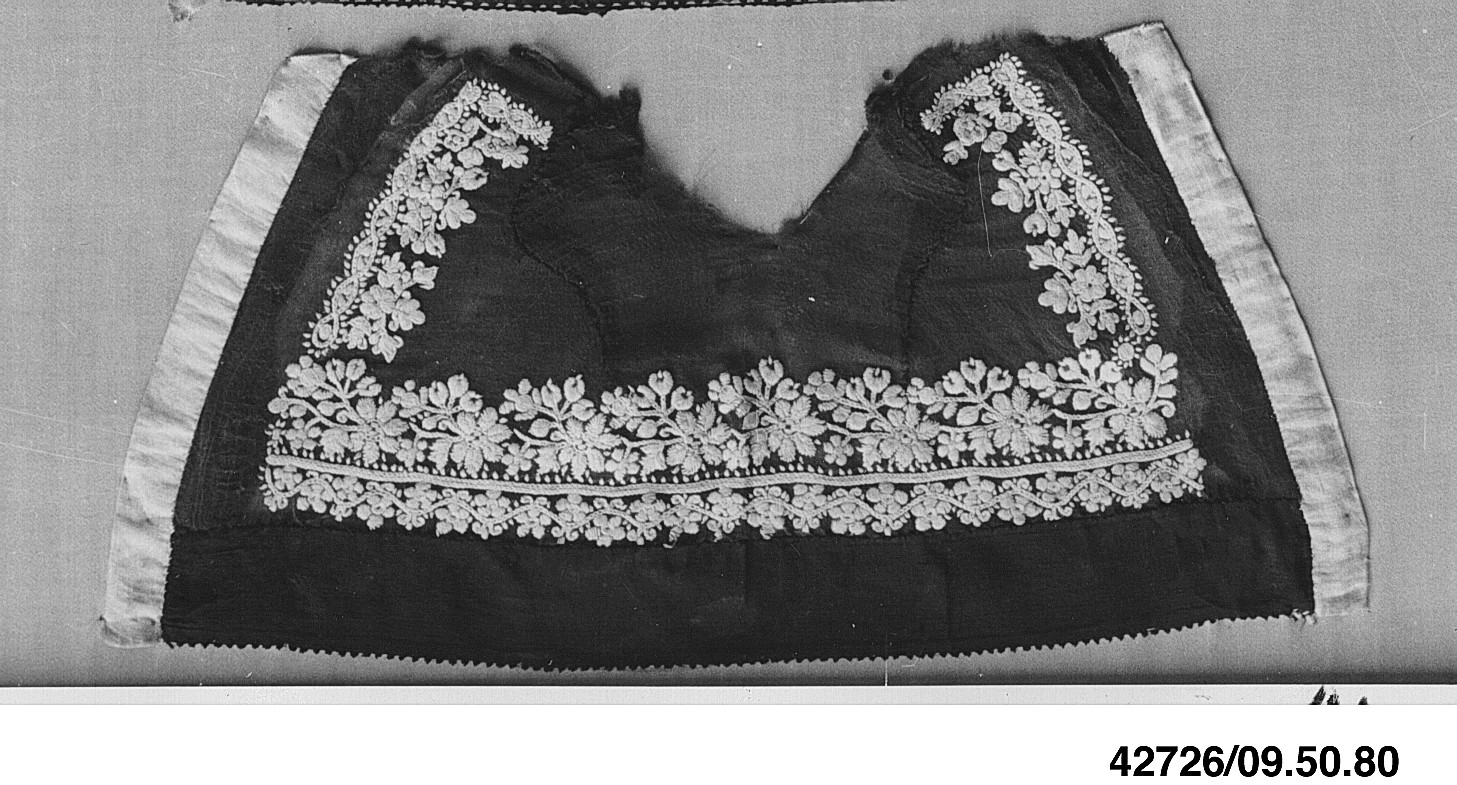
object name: fragment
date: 1801-1833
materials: silk